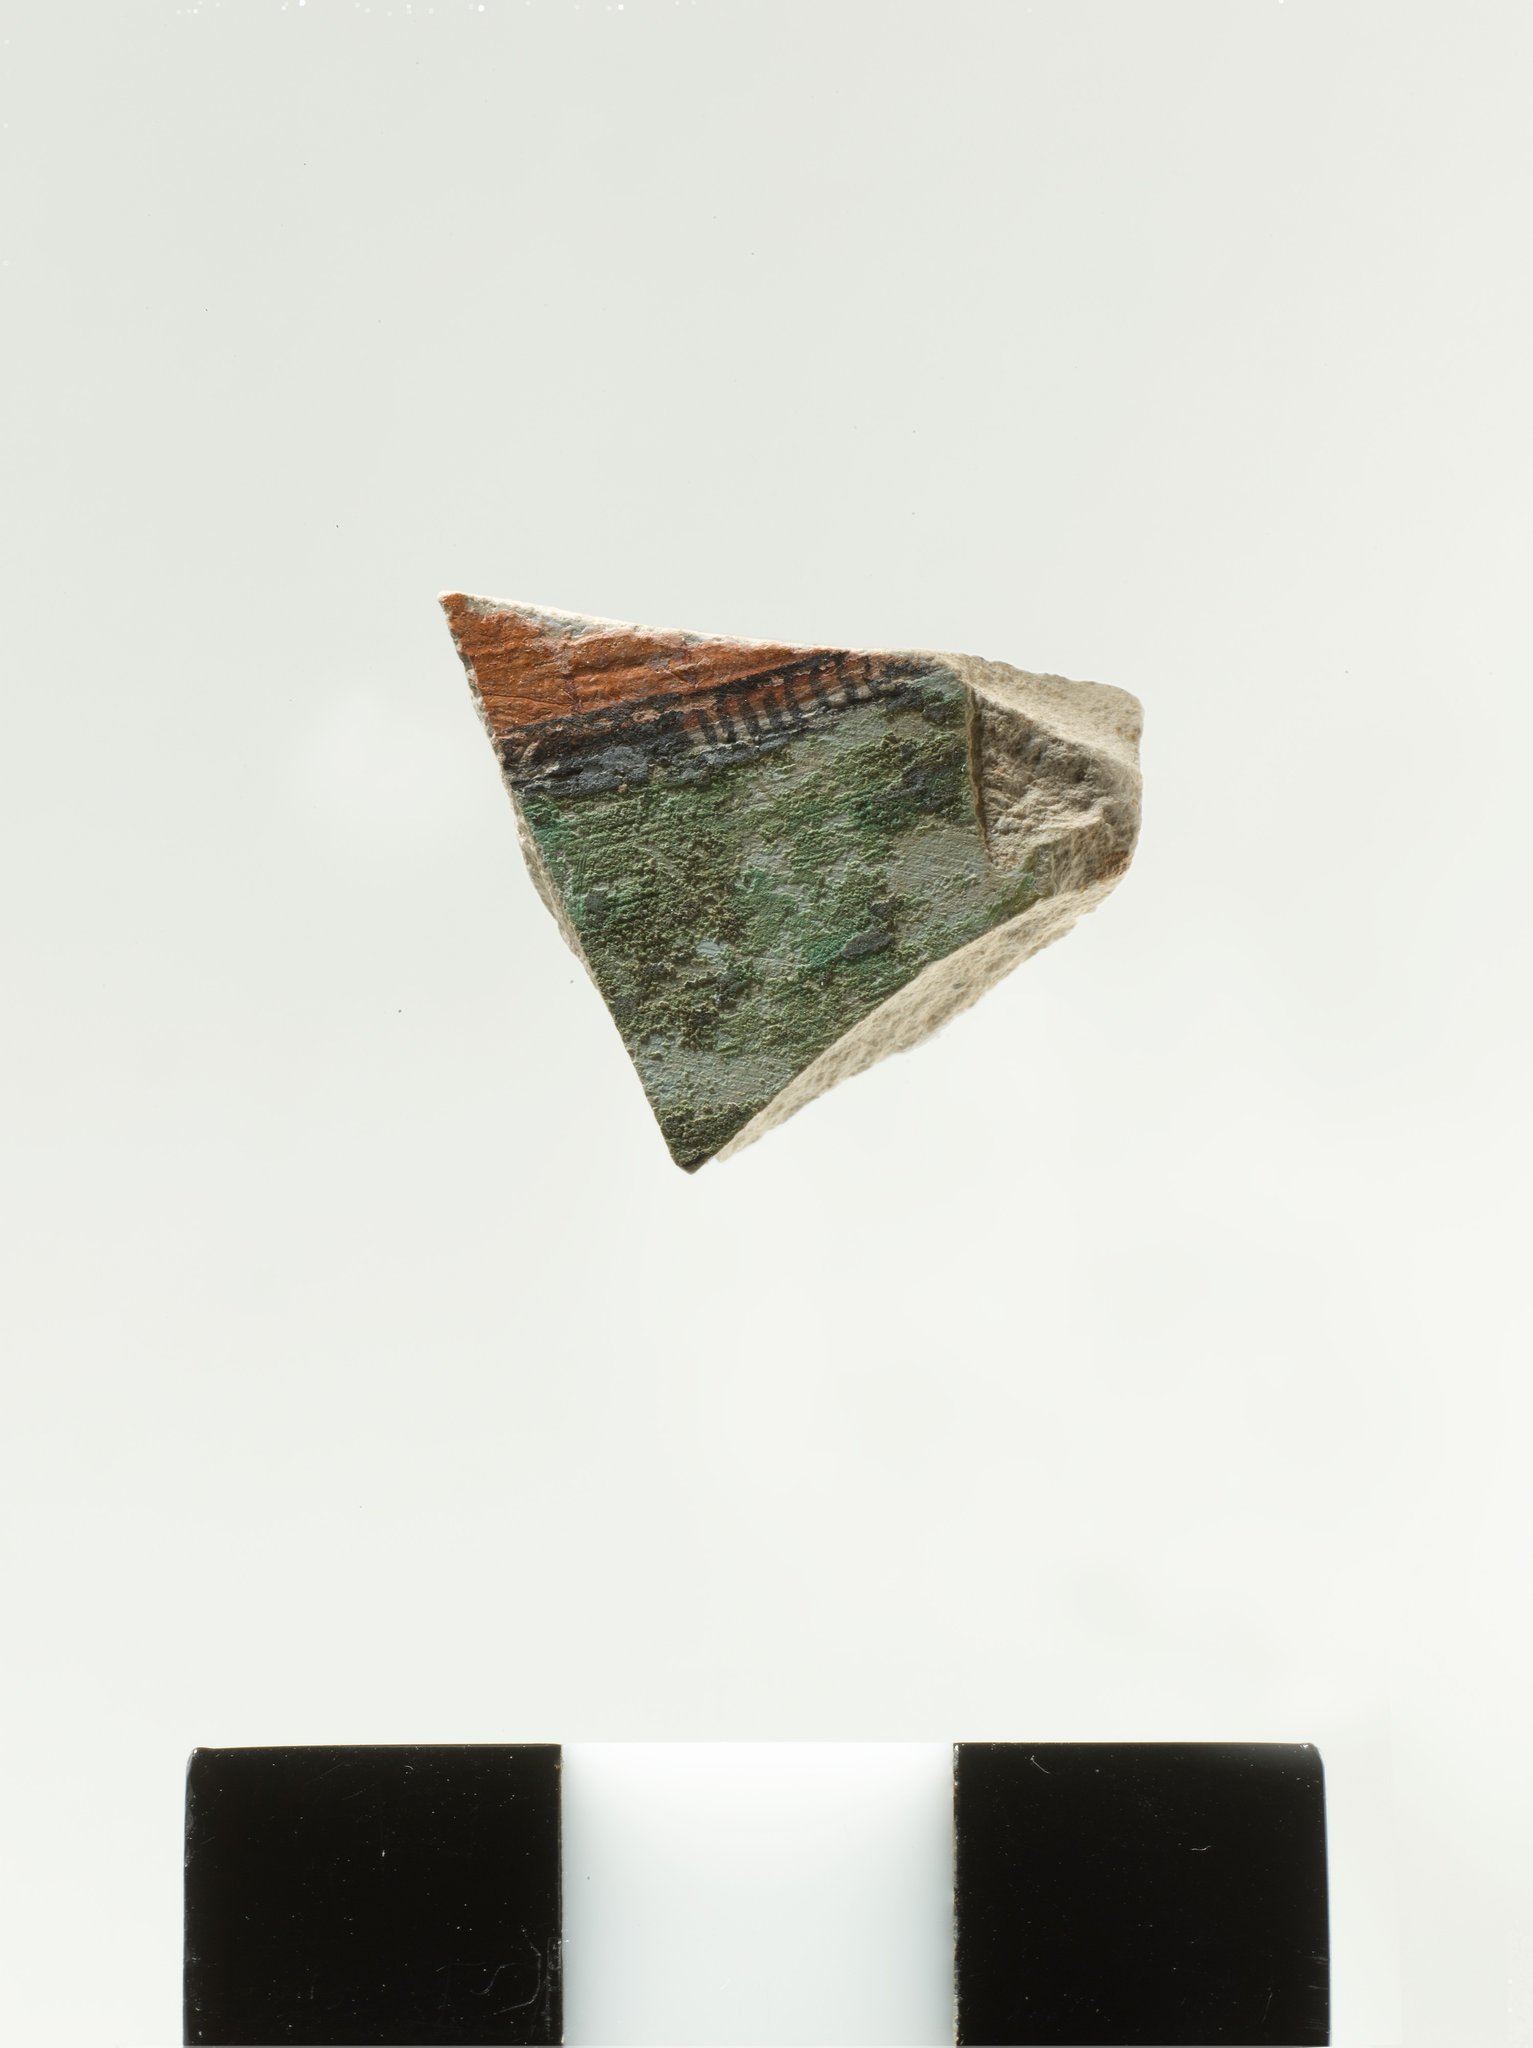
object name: relief fragment, tomb of meketre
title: Reliefs from the tomb of Meketre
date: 1981-1975 BCE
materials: limestone, paint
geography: egypt